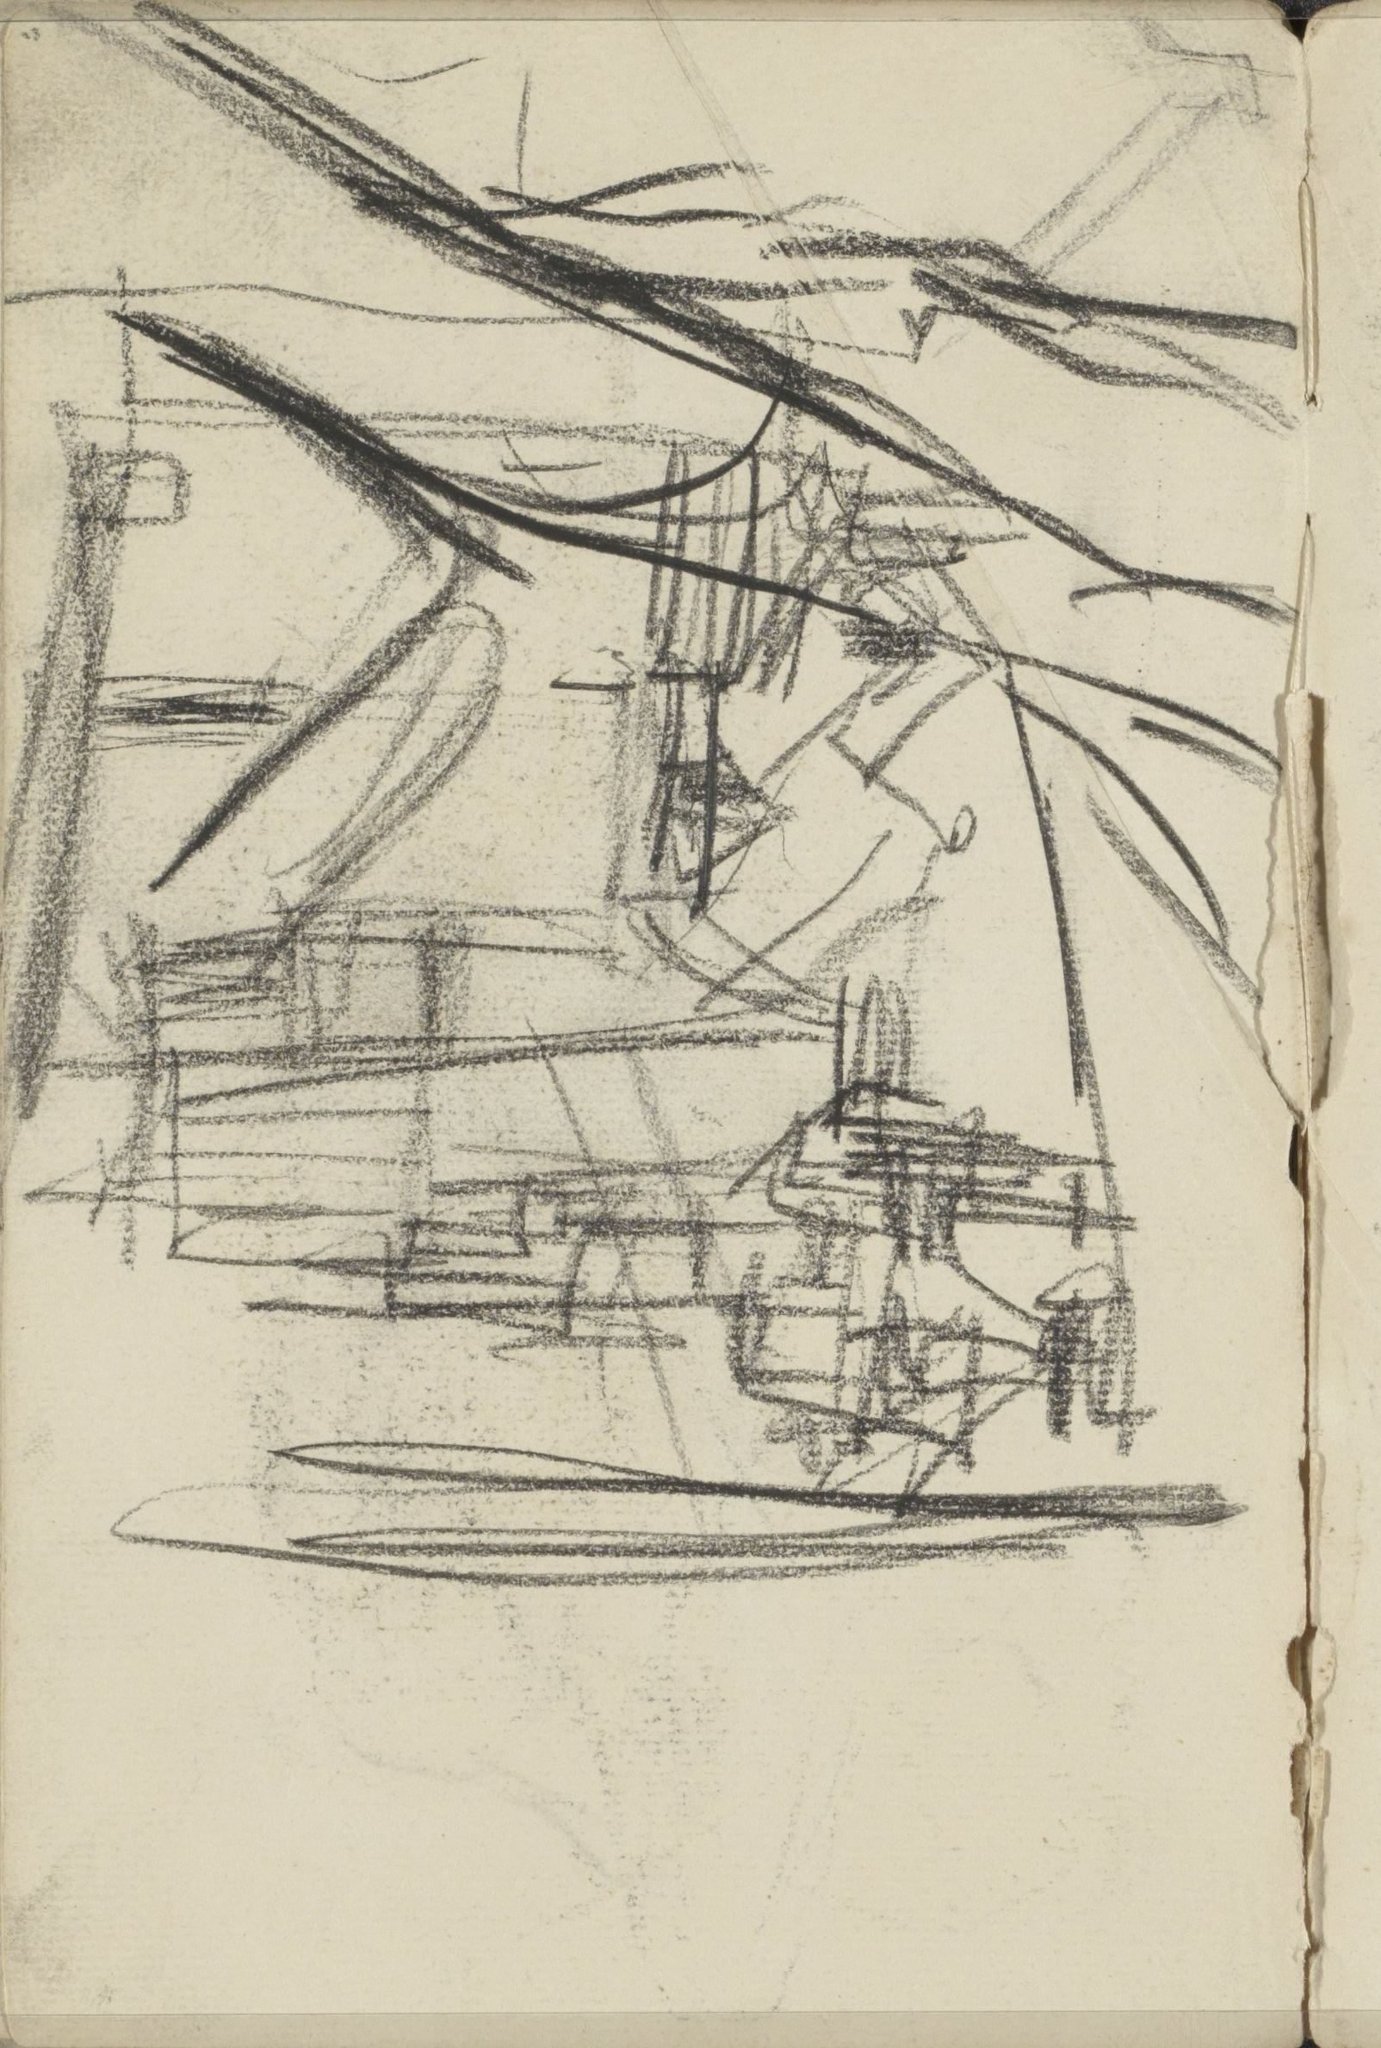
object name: sketchbook leaf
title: Gezicht op gebouwen in Amsterdam, mogelijk aan de Reguliersgracht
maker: george hendrik breitner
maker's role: draughtsman, painter, print maker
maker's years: 1857-1923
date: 1886-1923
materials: chalk, paper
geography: amsterdam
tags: trees, civic architecture; edifices; dwellings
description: Vooraan bomen. Pagina 23 uit een schetsboek met 13 bladen.